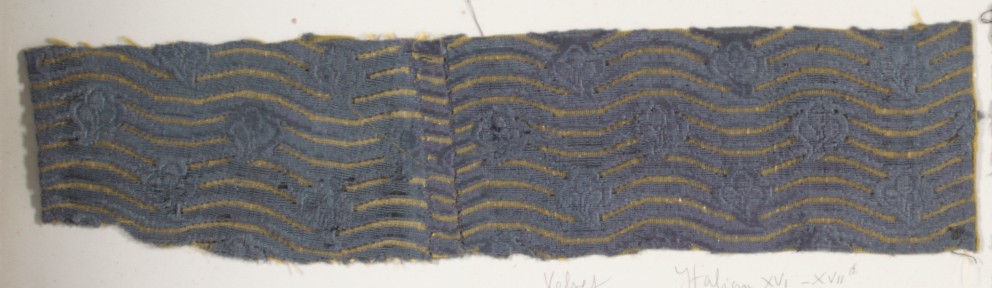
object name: fragment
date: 1501-1700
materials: metal thread, silk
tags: flowers